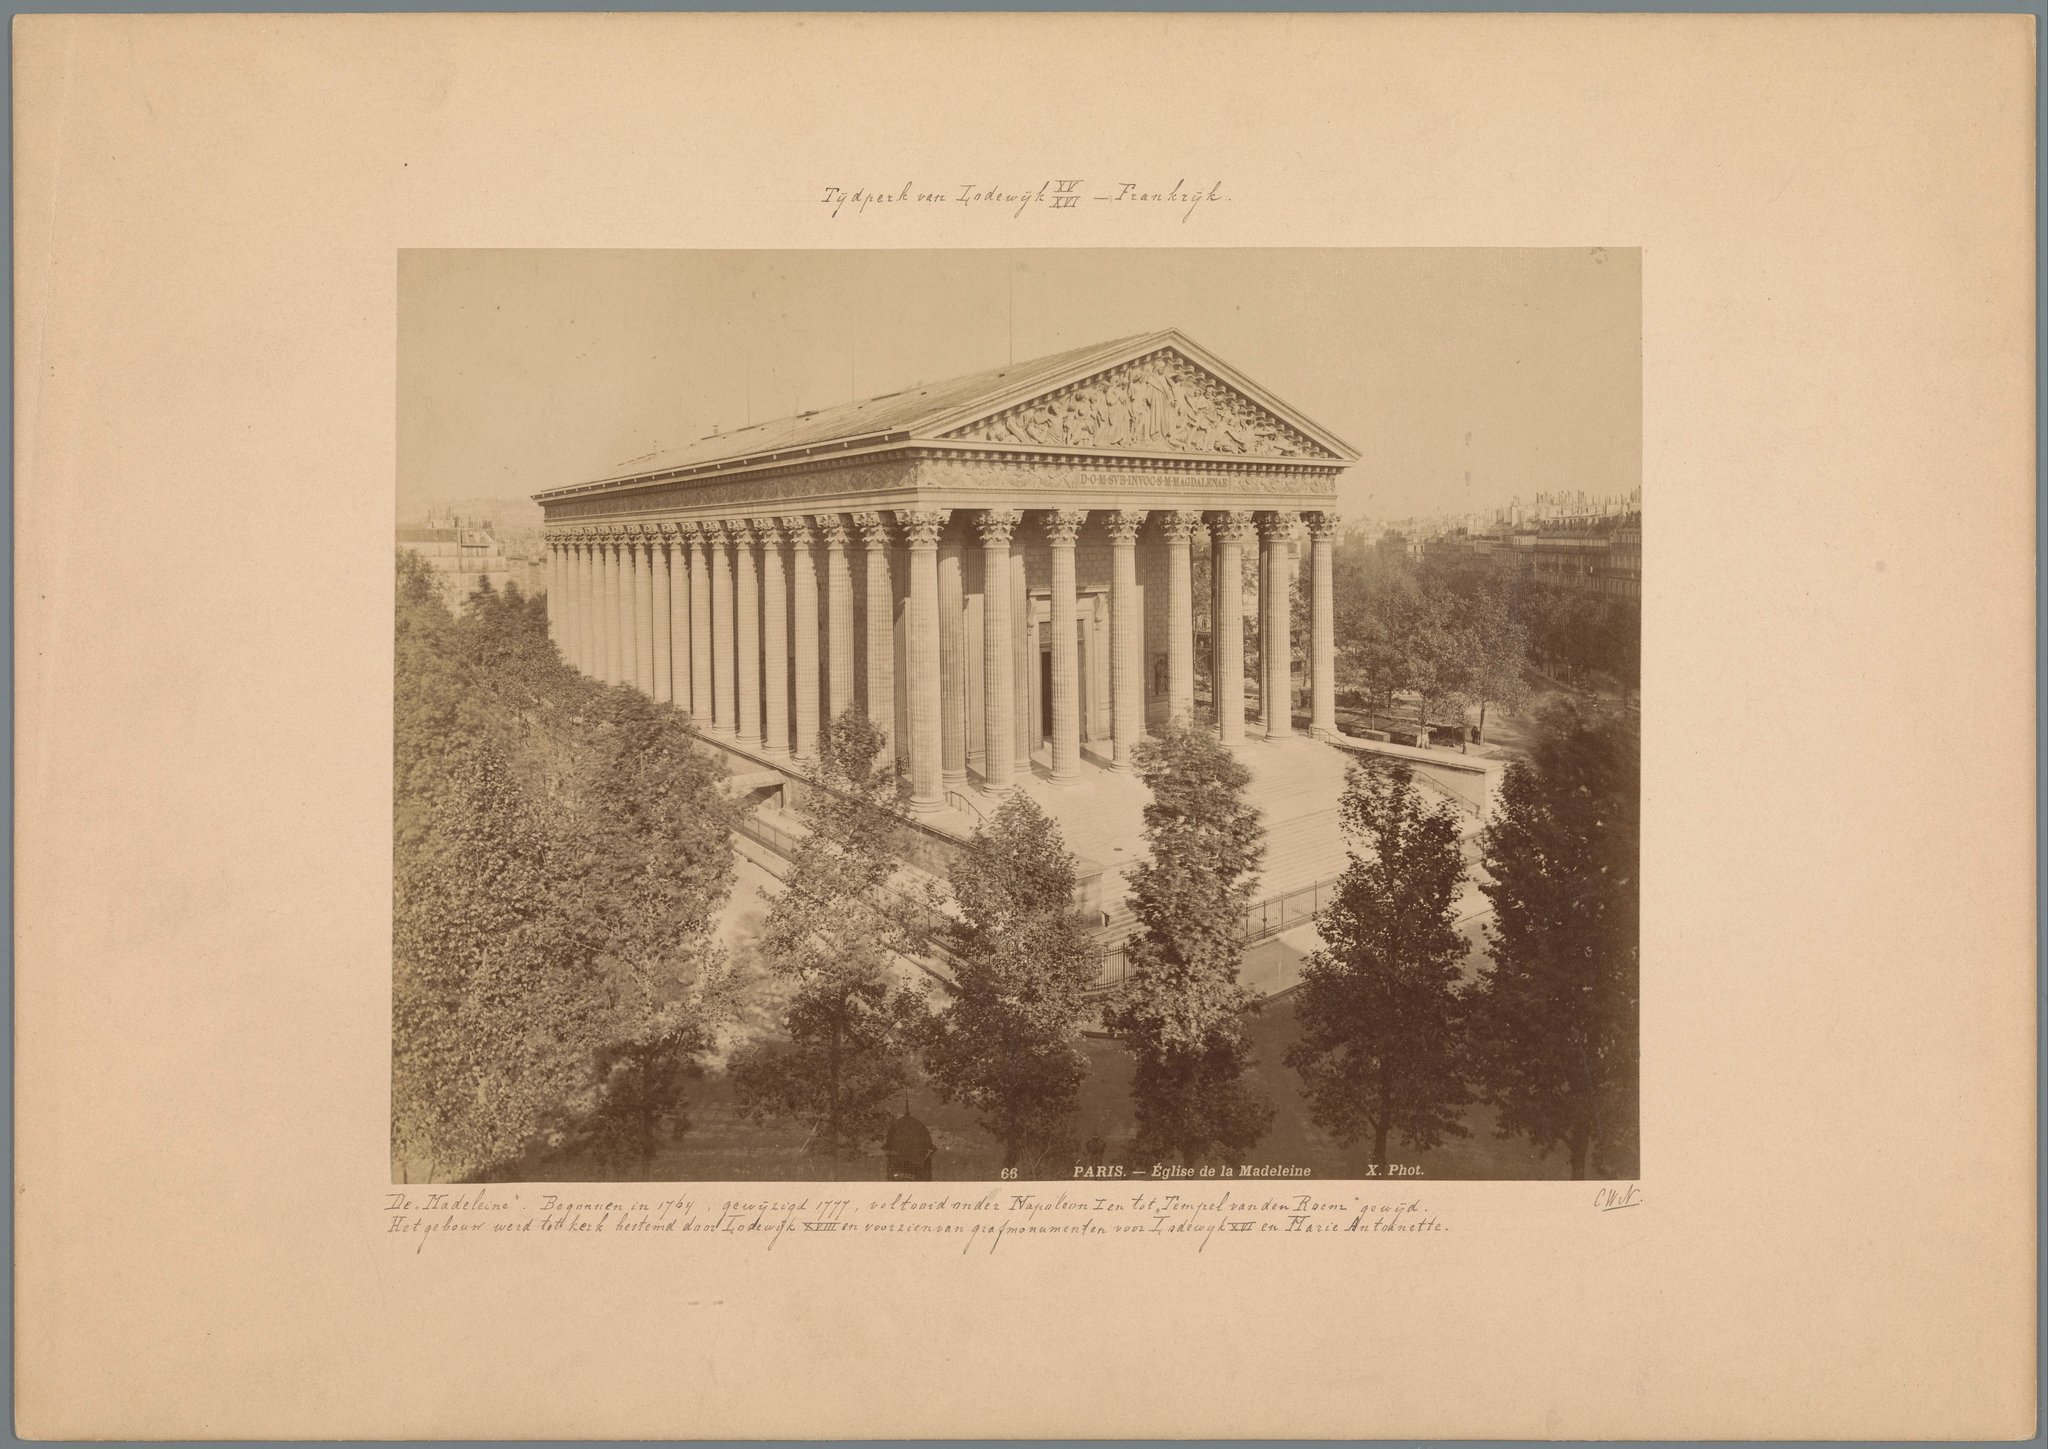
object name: photograph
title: Gezicht op La Madeleine te Parijs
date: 1875-1900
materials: cardboard, photographic support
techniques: albumen print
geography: paris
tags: other architectural details (with name), church (exterior)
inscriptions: collector's mark: ‘KUNSTNIJVERHEIDSCHOOL QUELLINUS AMSTERDAM FRANS HALSSTRAAT 14.’, inscription: ‘CWN.’, inscription: ‘Tijdperk van Lodwijk XV XVI - Frankrijk.’, number: ‘66’, collector's mark: ‘INSTITUUT VOOR KUNST-NIJVERHEIDSONDERWIJS GABRIËL METSUSTRAAT No. 16 AMSTERDAM’